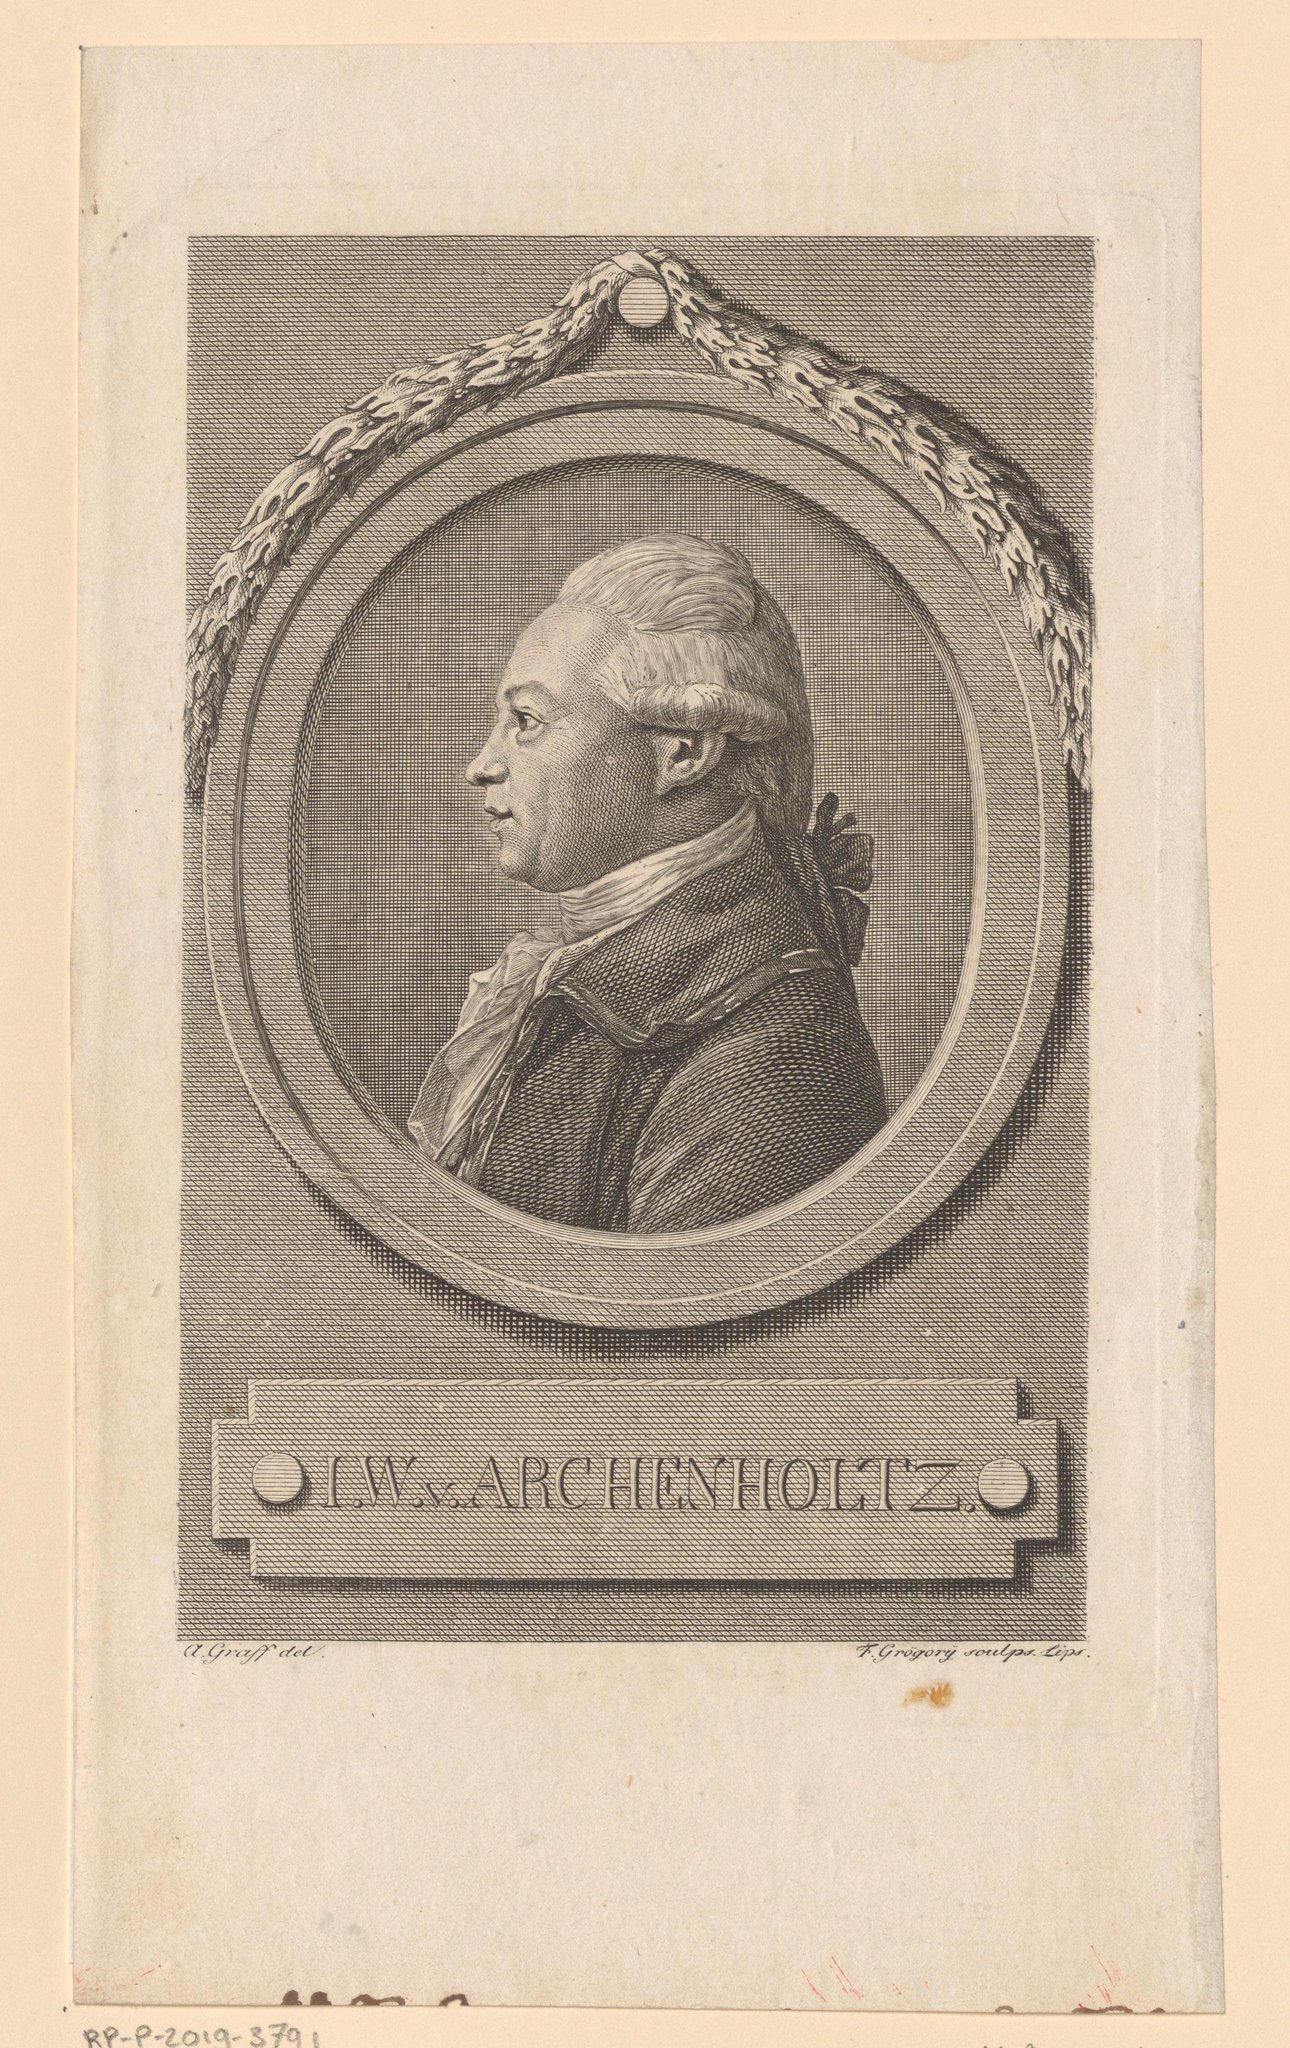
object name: book illustration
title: Portret van Johann Wilhelm von Archenholz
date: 1786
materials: paper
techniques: engraving, etching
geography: leipzig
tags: historical persons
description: Prent uit: Neue Bibliothek der schönen Wissenschaften und der freyen Künste. Leipzig: Johann Gottfried Dyck, 1786, dl. 32.